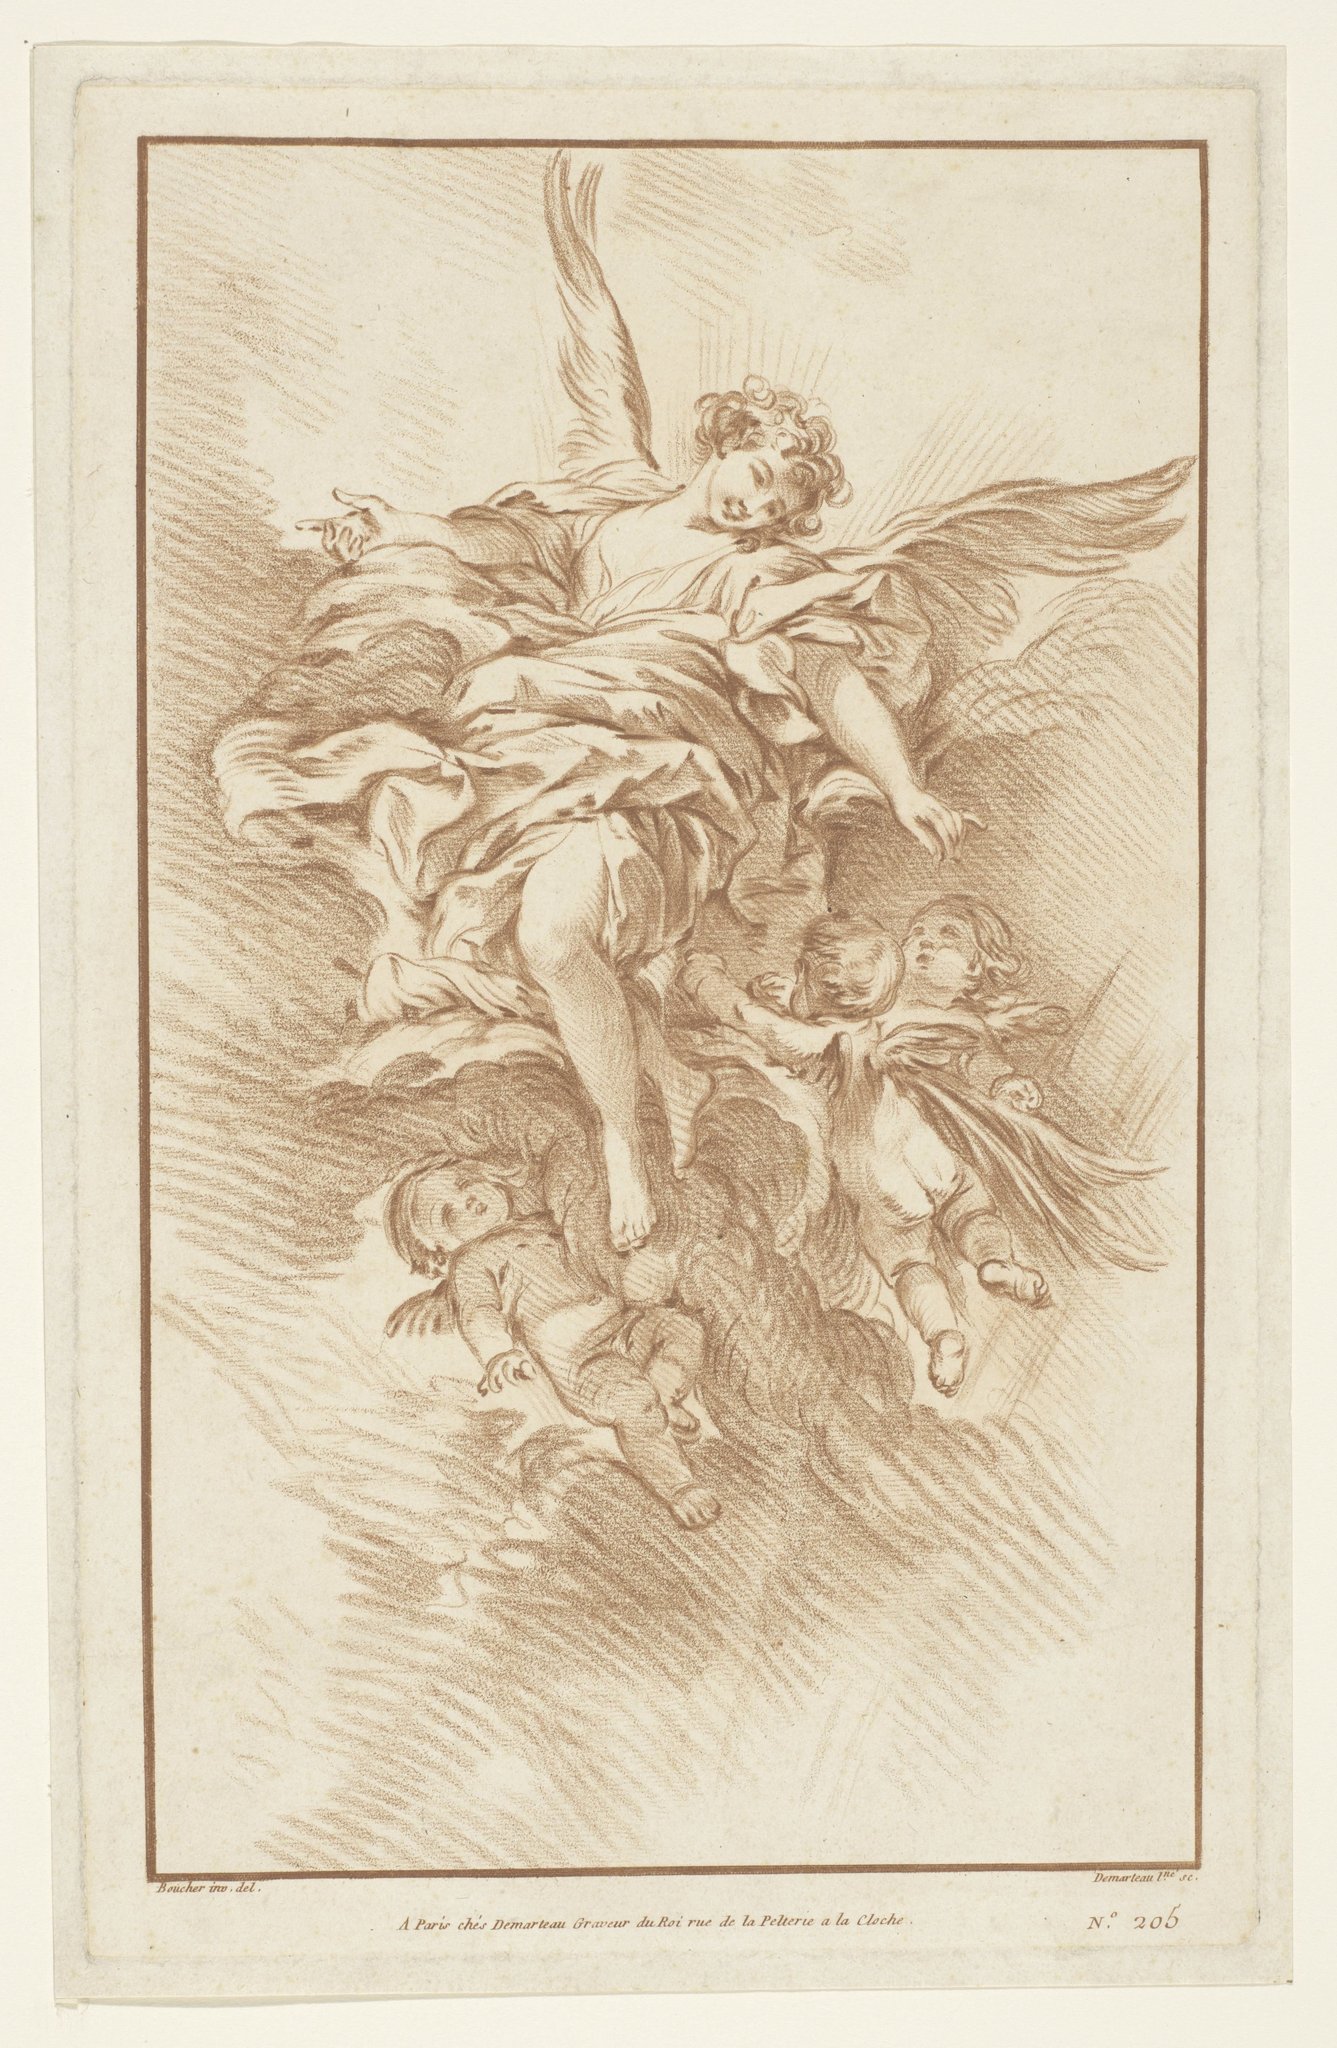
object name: print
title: Engel met drie putti in wolken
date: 1732-1776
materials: paper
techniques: printmaking, etching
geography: paris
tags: cupids: 'amores', 'amoretti', 'putti', angels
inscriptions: collector's mark: Lugt 2228, collector's mark: Lugt 975